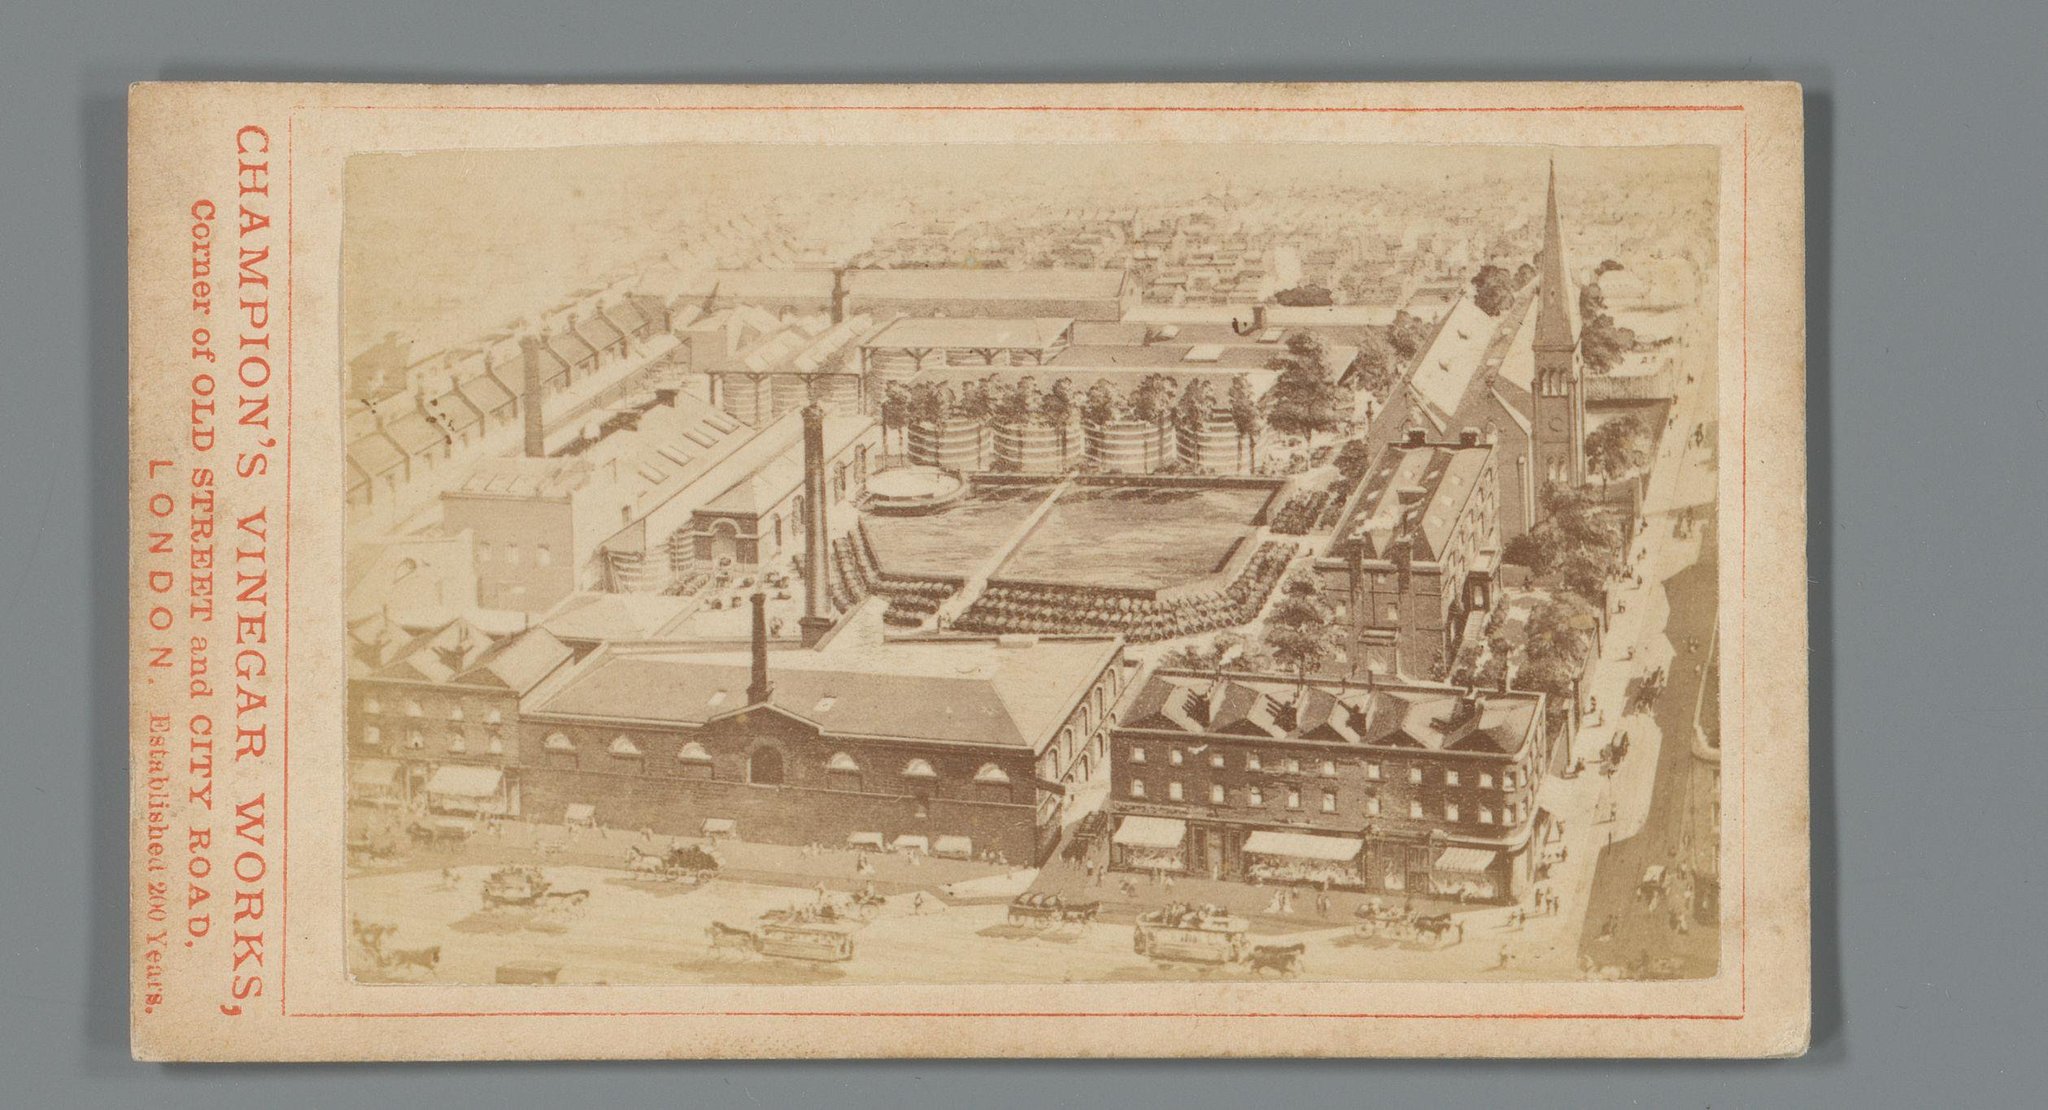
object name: carte de visite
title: Gezicht op de fabriek van Champion's Vinegar Works in Londen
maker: Anonymous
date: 1850-1907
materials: cardboard, photographic support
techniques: albumen print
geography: london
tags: advertising, vinegar, industrial production, exterior of industrial structures, factories, industries ~ food, drink, stimulants, london